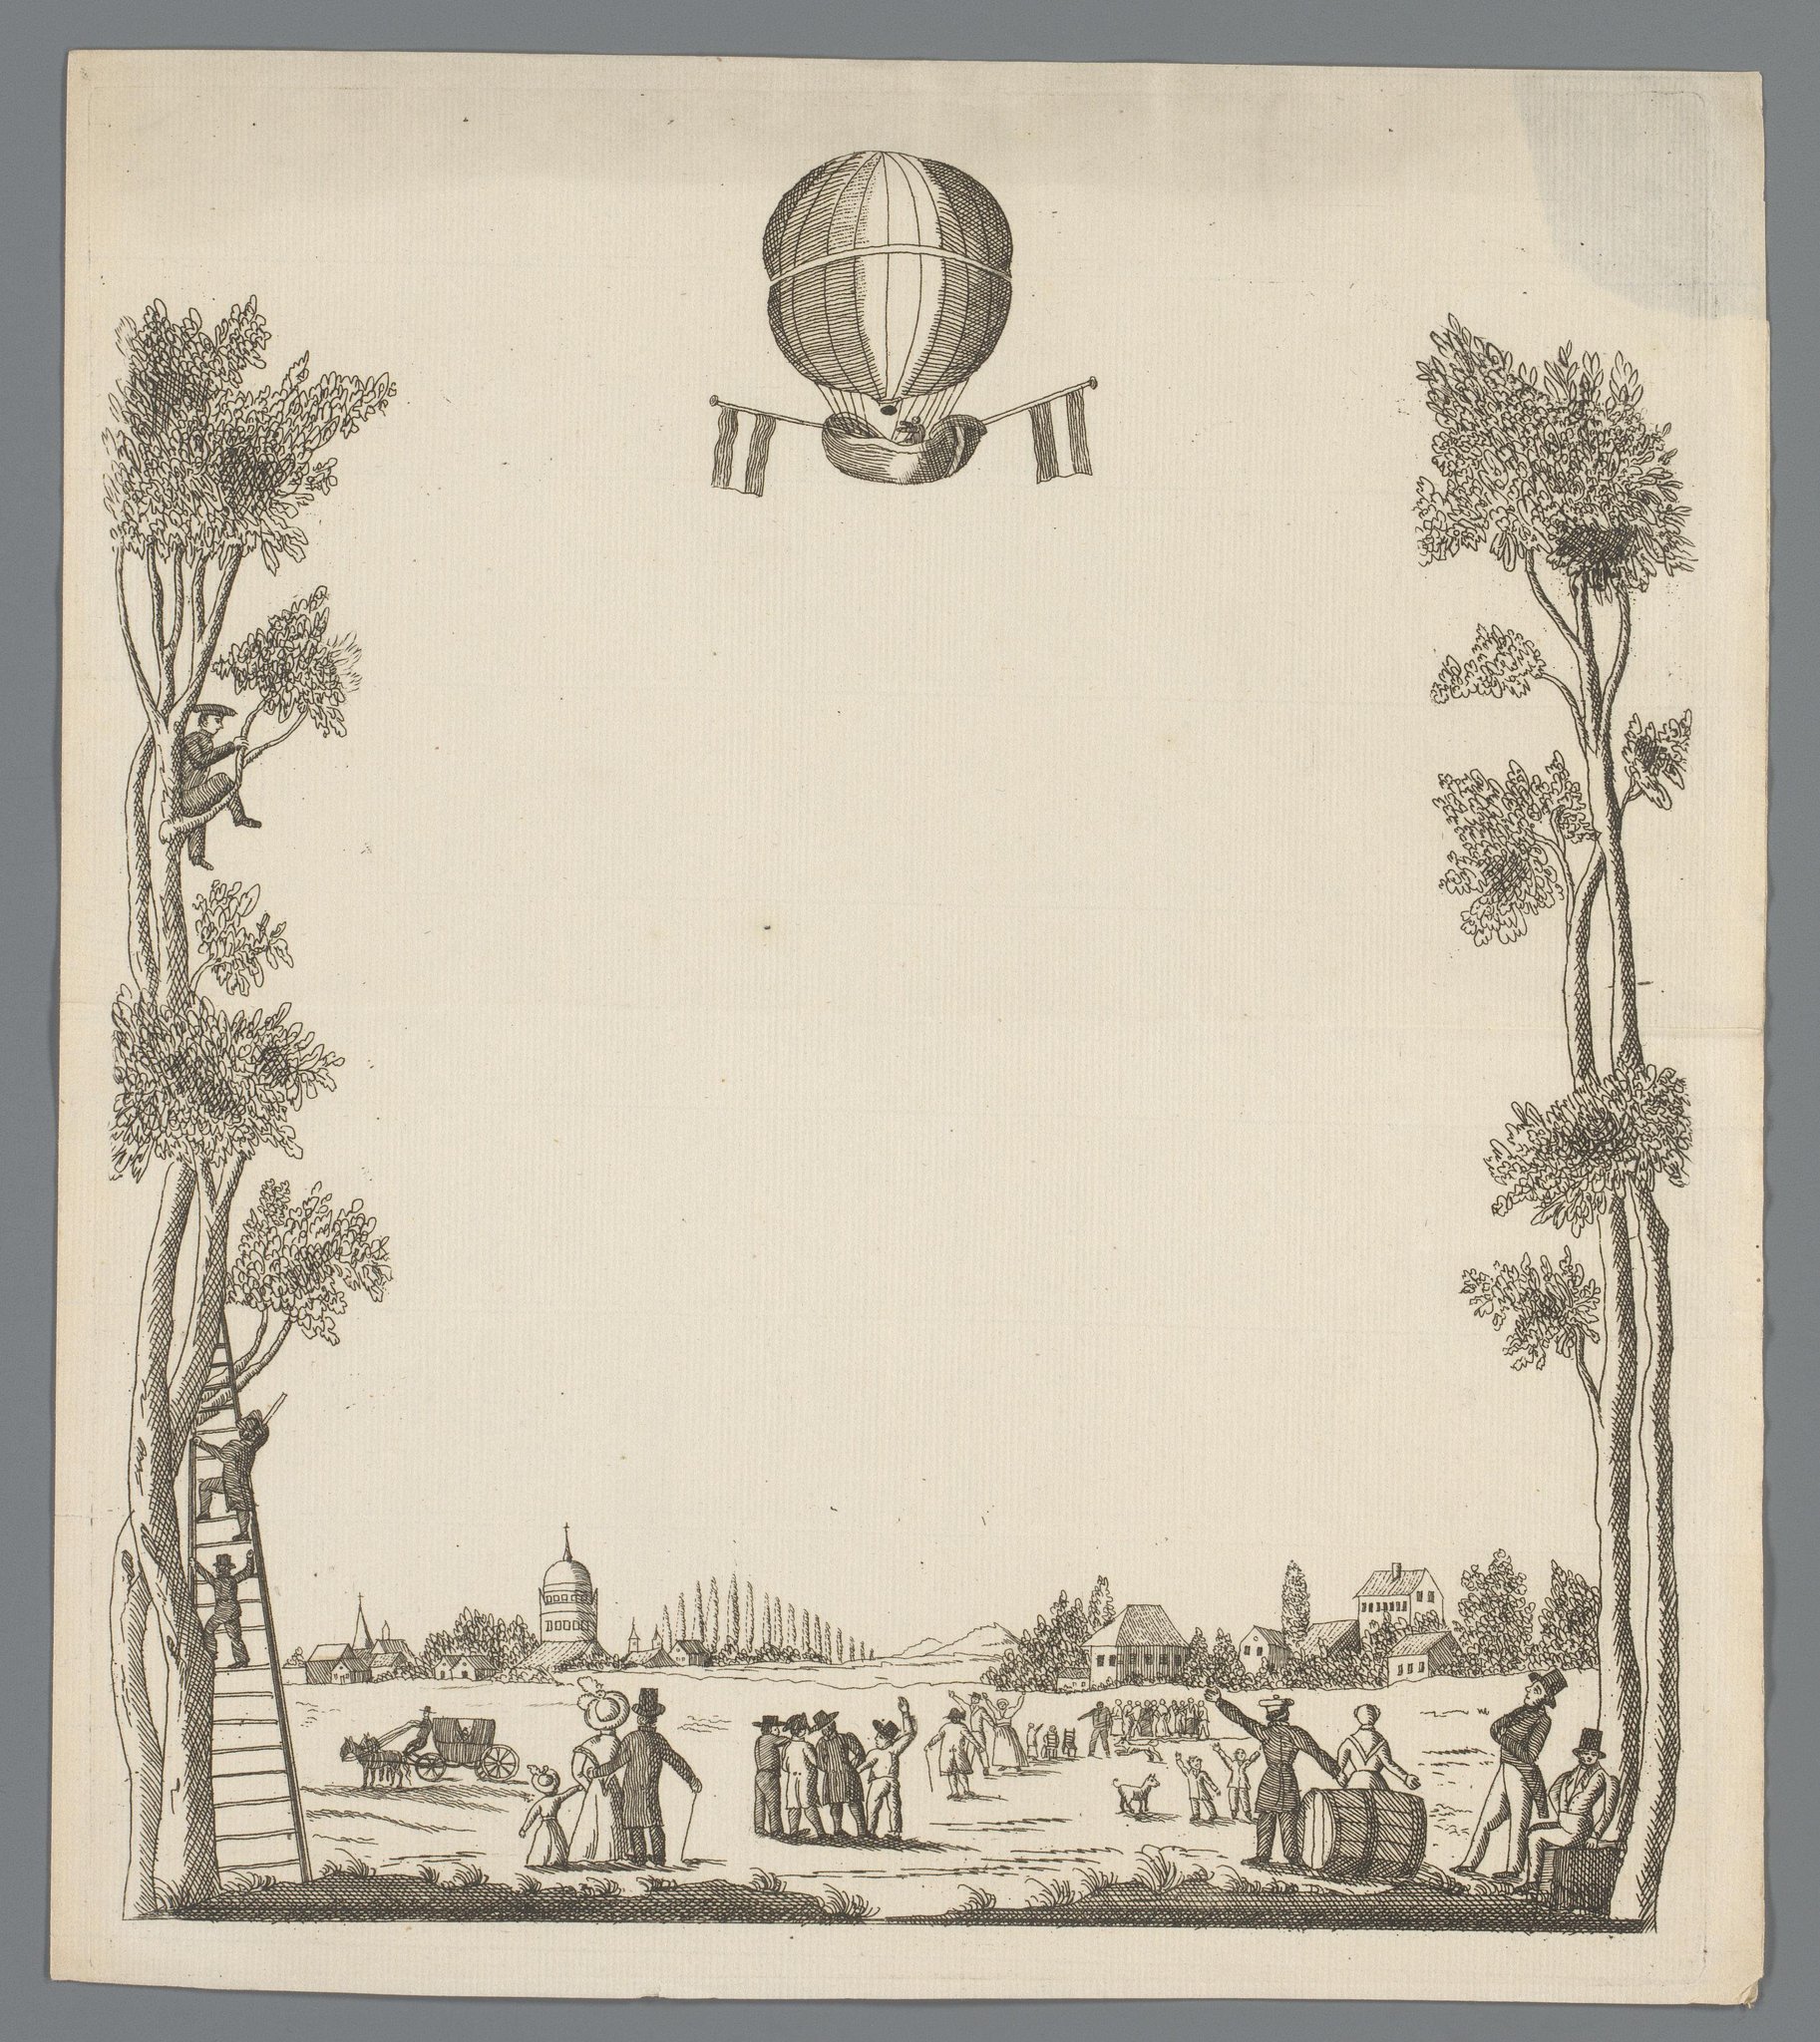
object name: print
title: Wensbrief met voorstelling van het oplaten van een luchtballon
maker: Anonymous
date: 1750-1850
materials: paper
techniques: etching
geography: netherlands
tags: balloon (aviation)